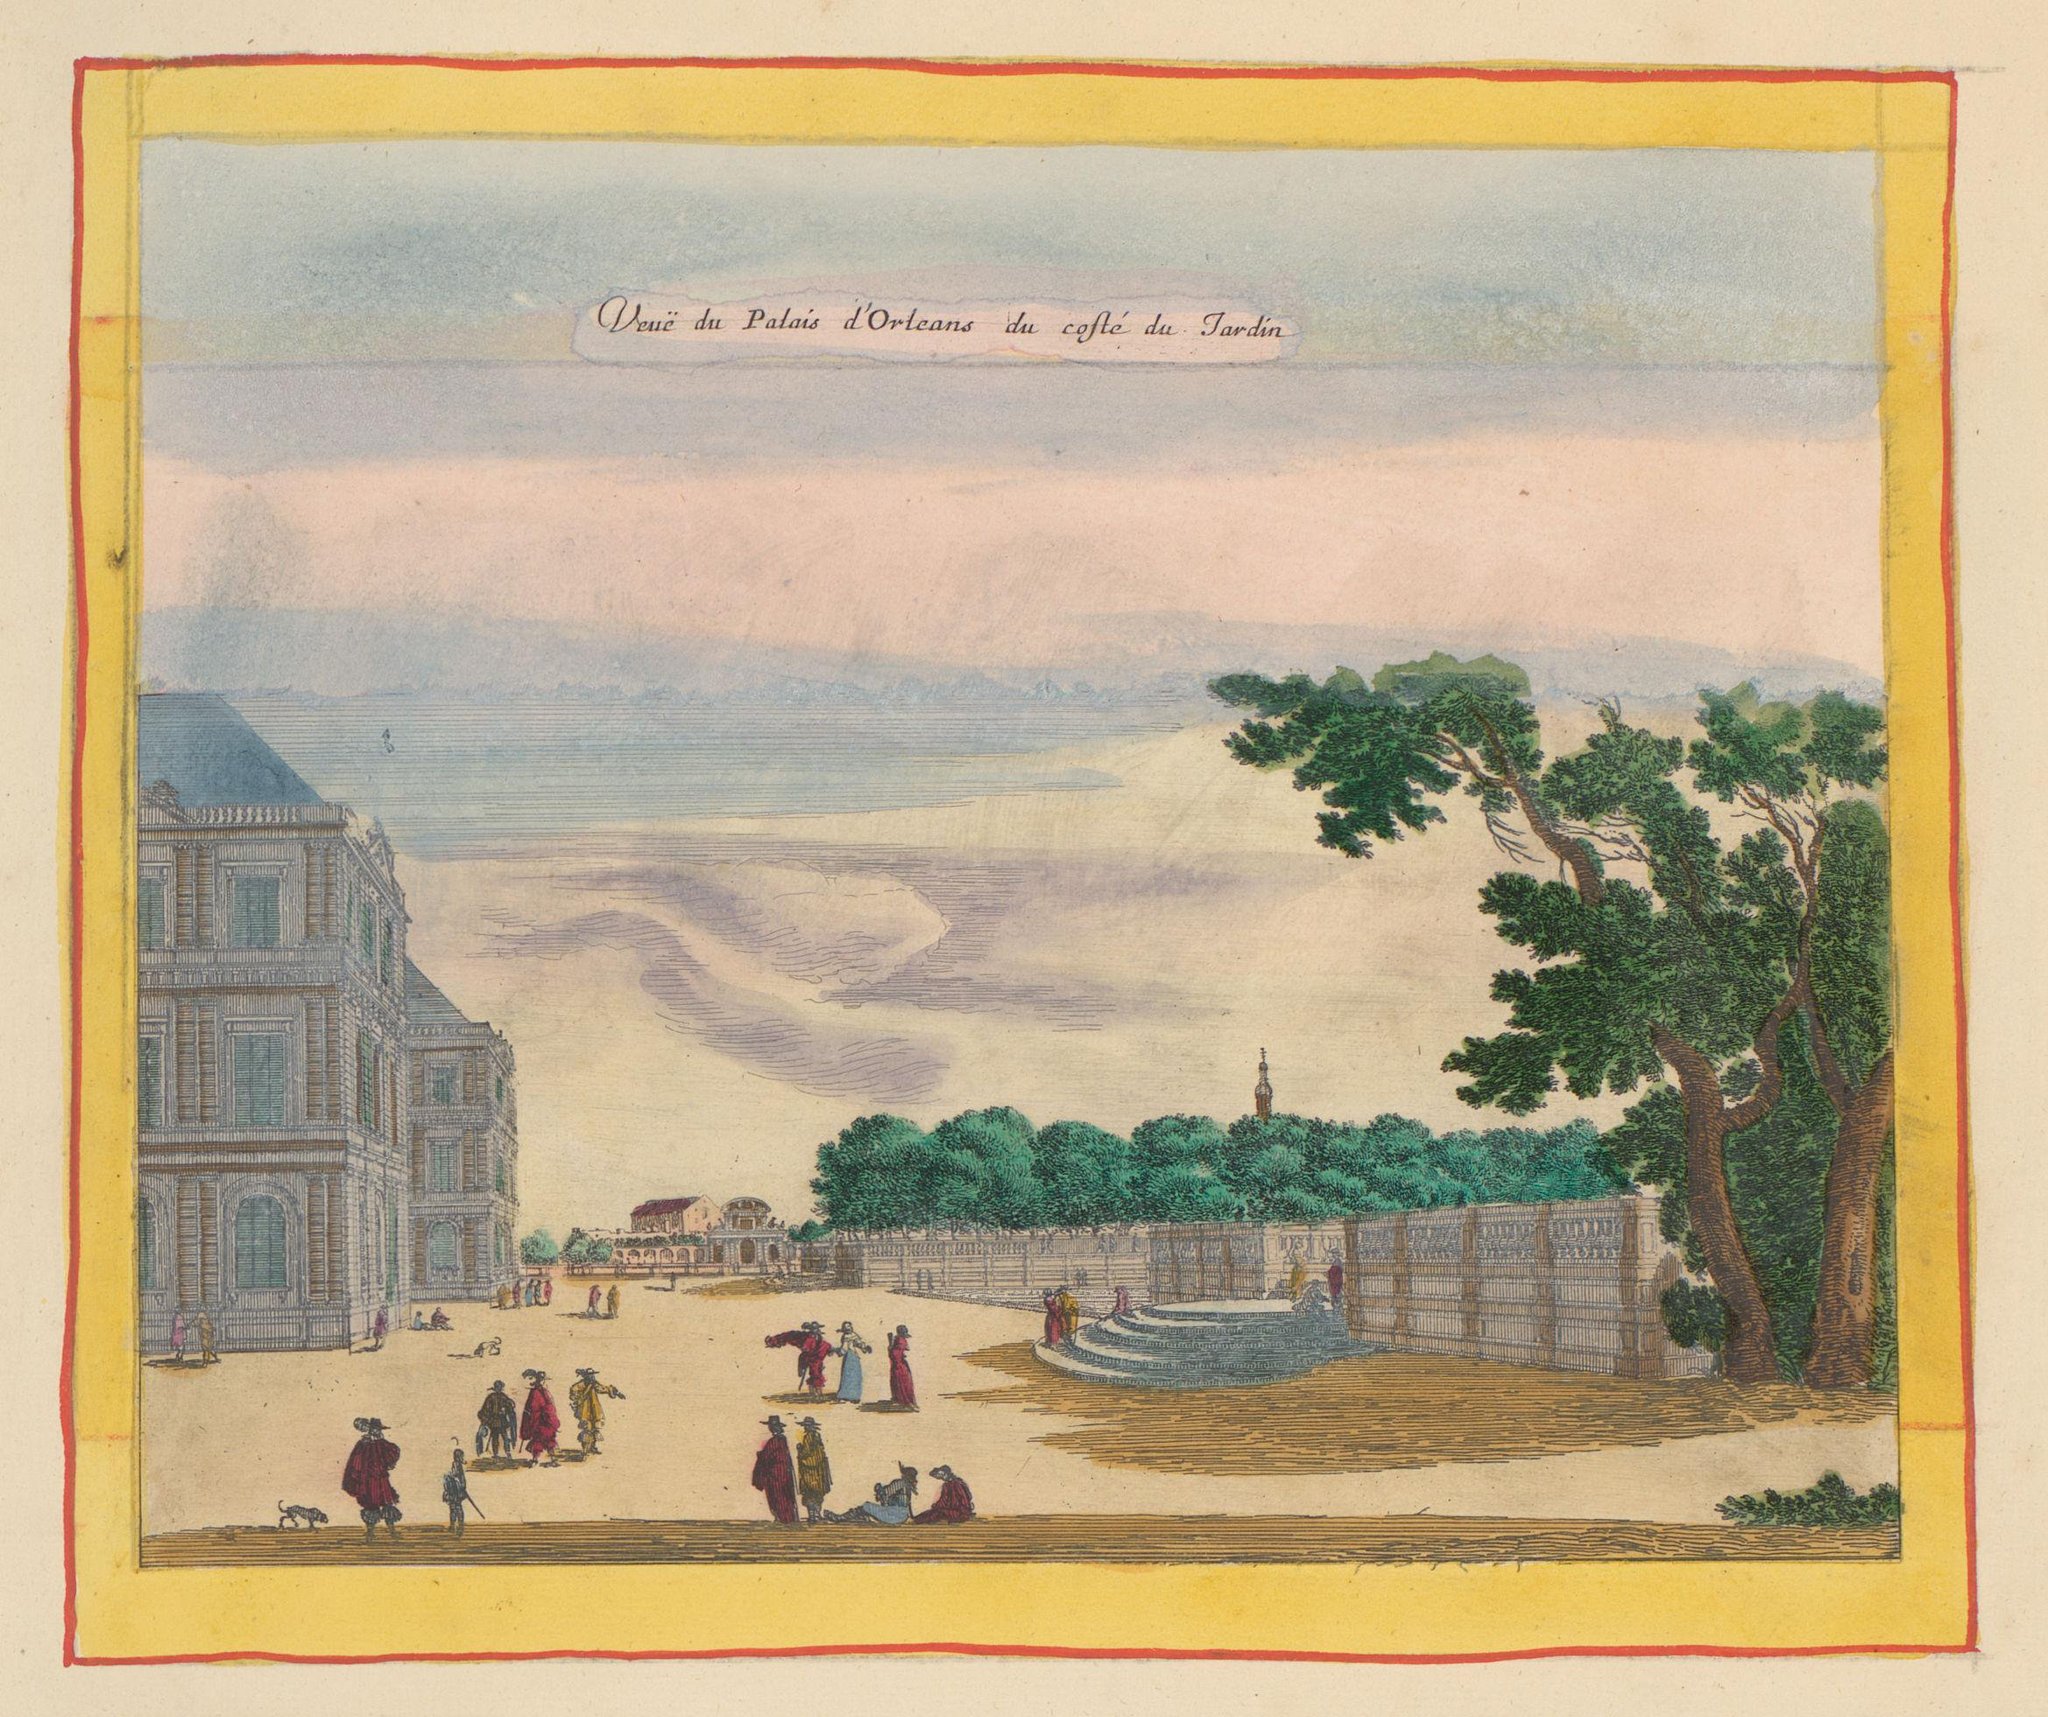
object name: print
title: Gezicht op de zijkant van Palais du Luxembourg en een ingang naar de tuinen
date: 1631-1661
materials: paper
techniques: etching, hand coloring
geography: paris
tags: palace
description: Gezicht op de zijkant van Palais du Luxembourg links en een ingang naar de tuinen rechts. Prent maakt deel uit van een album.